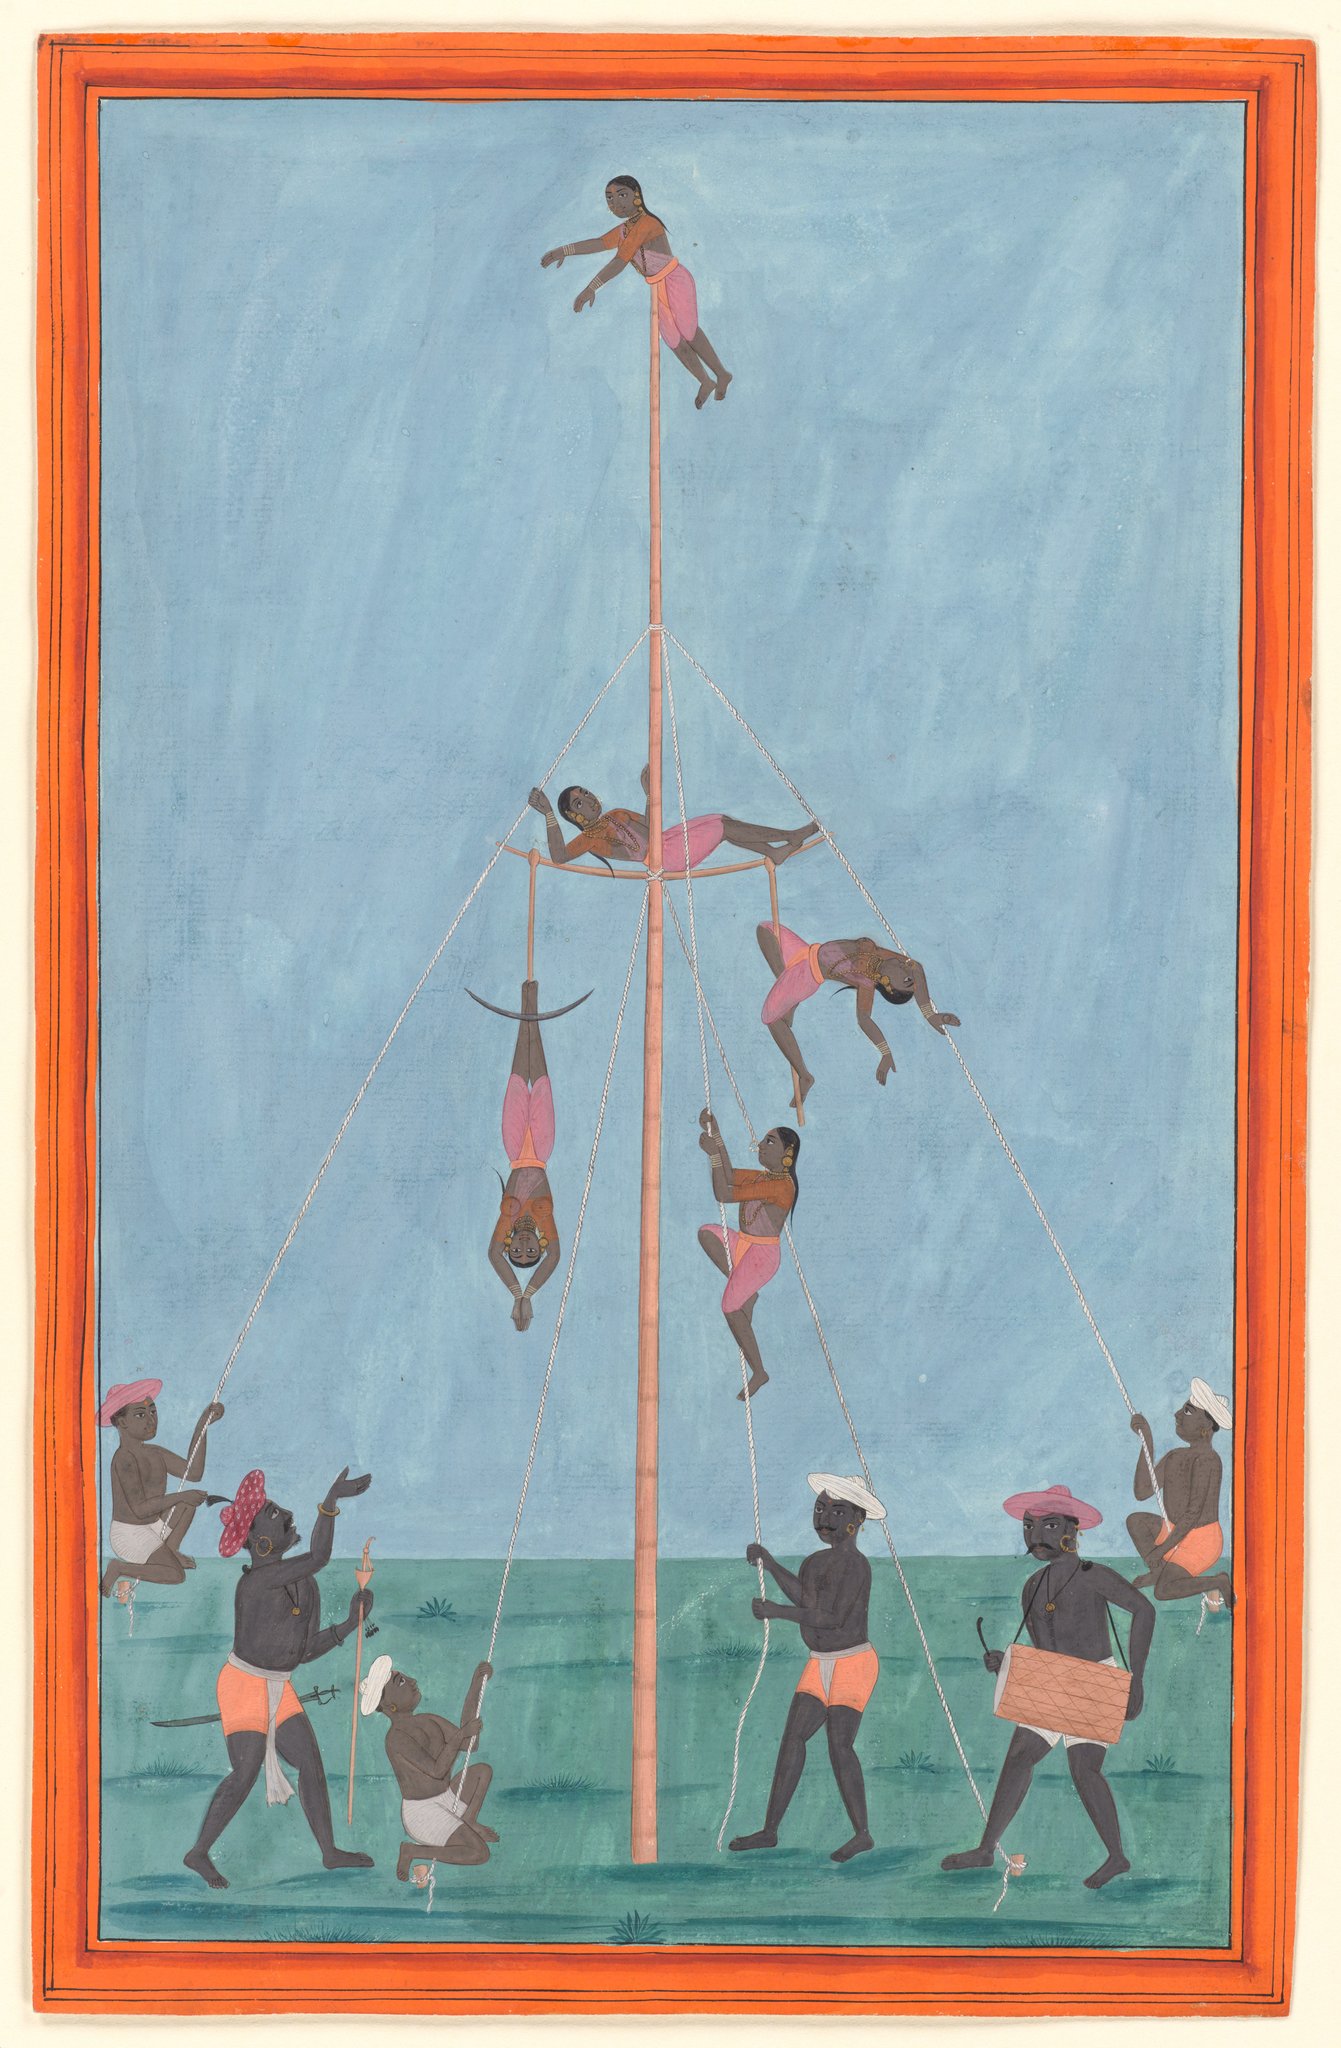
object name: folio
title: A troupe of acrobats performing daring feats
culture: indian, thanjavur, tamil nadu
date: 1781-1785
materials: paper, pigment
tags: acrobats